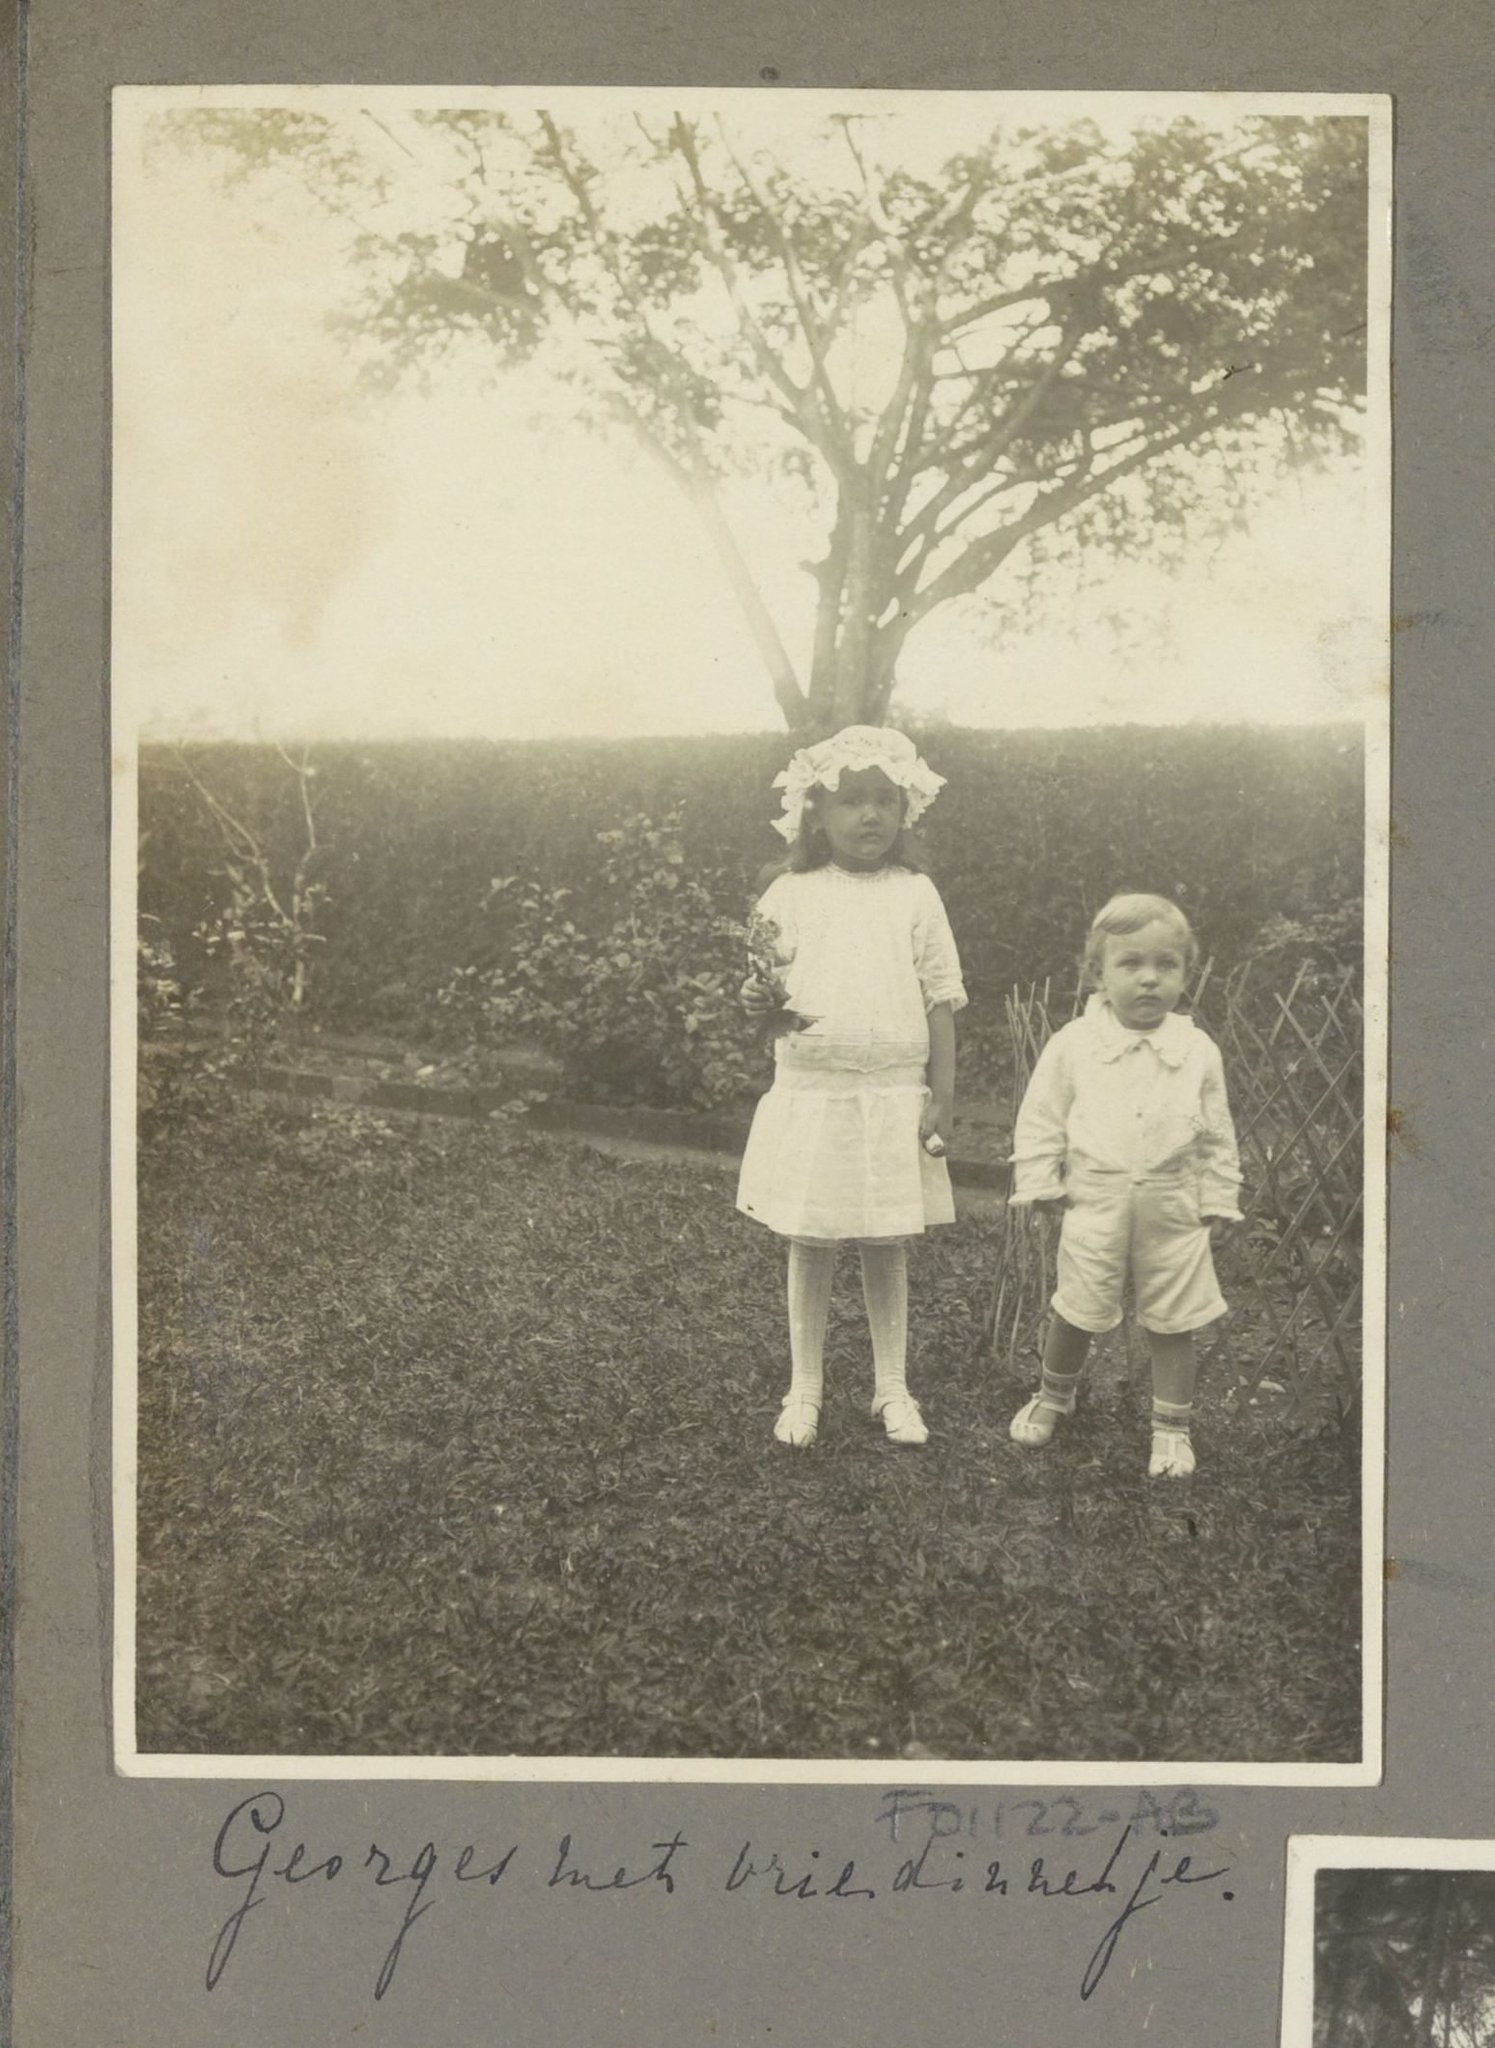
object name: photograph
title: Georges Bergsma en een vriendin op Sumatra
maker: Anonymous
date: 1917-1918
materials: photographic support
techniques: gelatin silver print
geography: sumatra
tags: utrecht, child, sumatra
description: Onderdeel van fotoalbum met opnames van de familie Bergsma in Tandjong Poera en Rantan Pandjang (Sumatra).